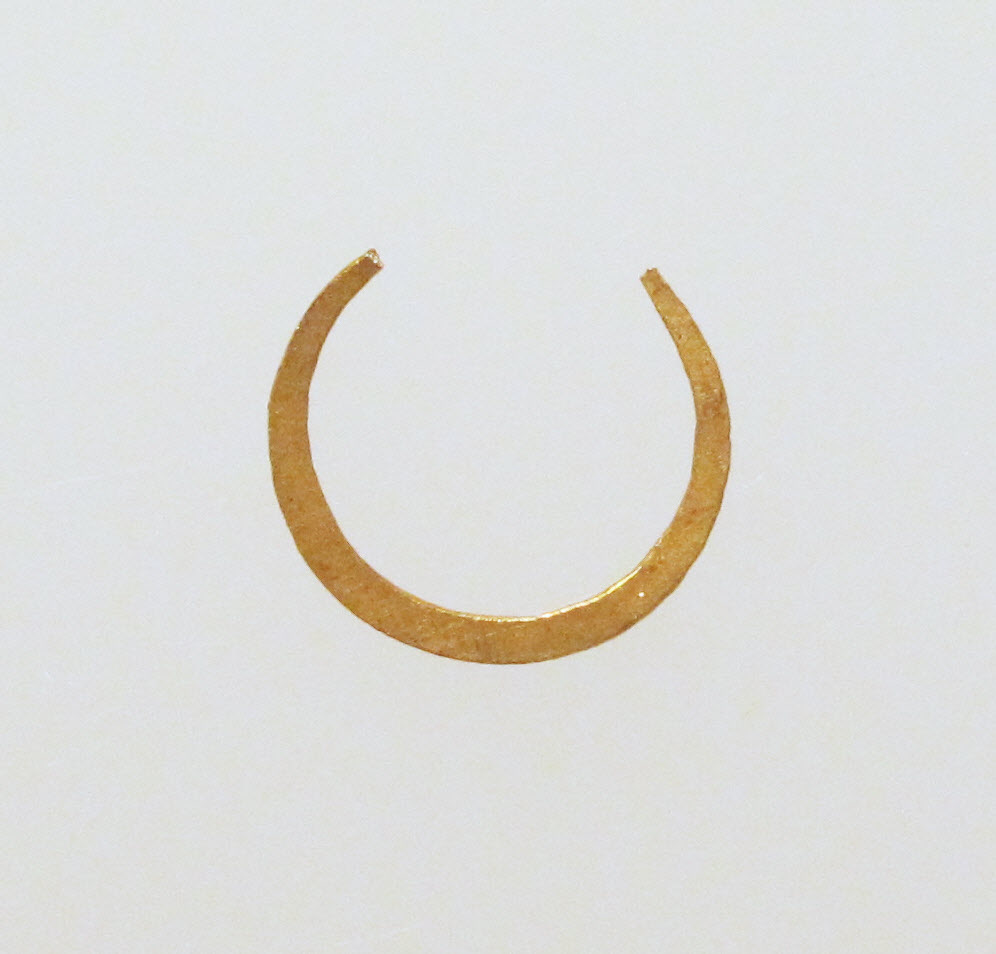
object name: earring loop type, hammered flat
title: Earring-loop type, hammered flat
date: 7000 BCE-330 CE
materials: gold